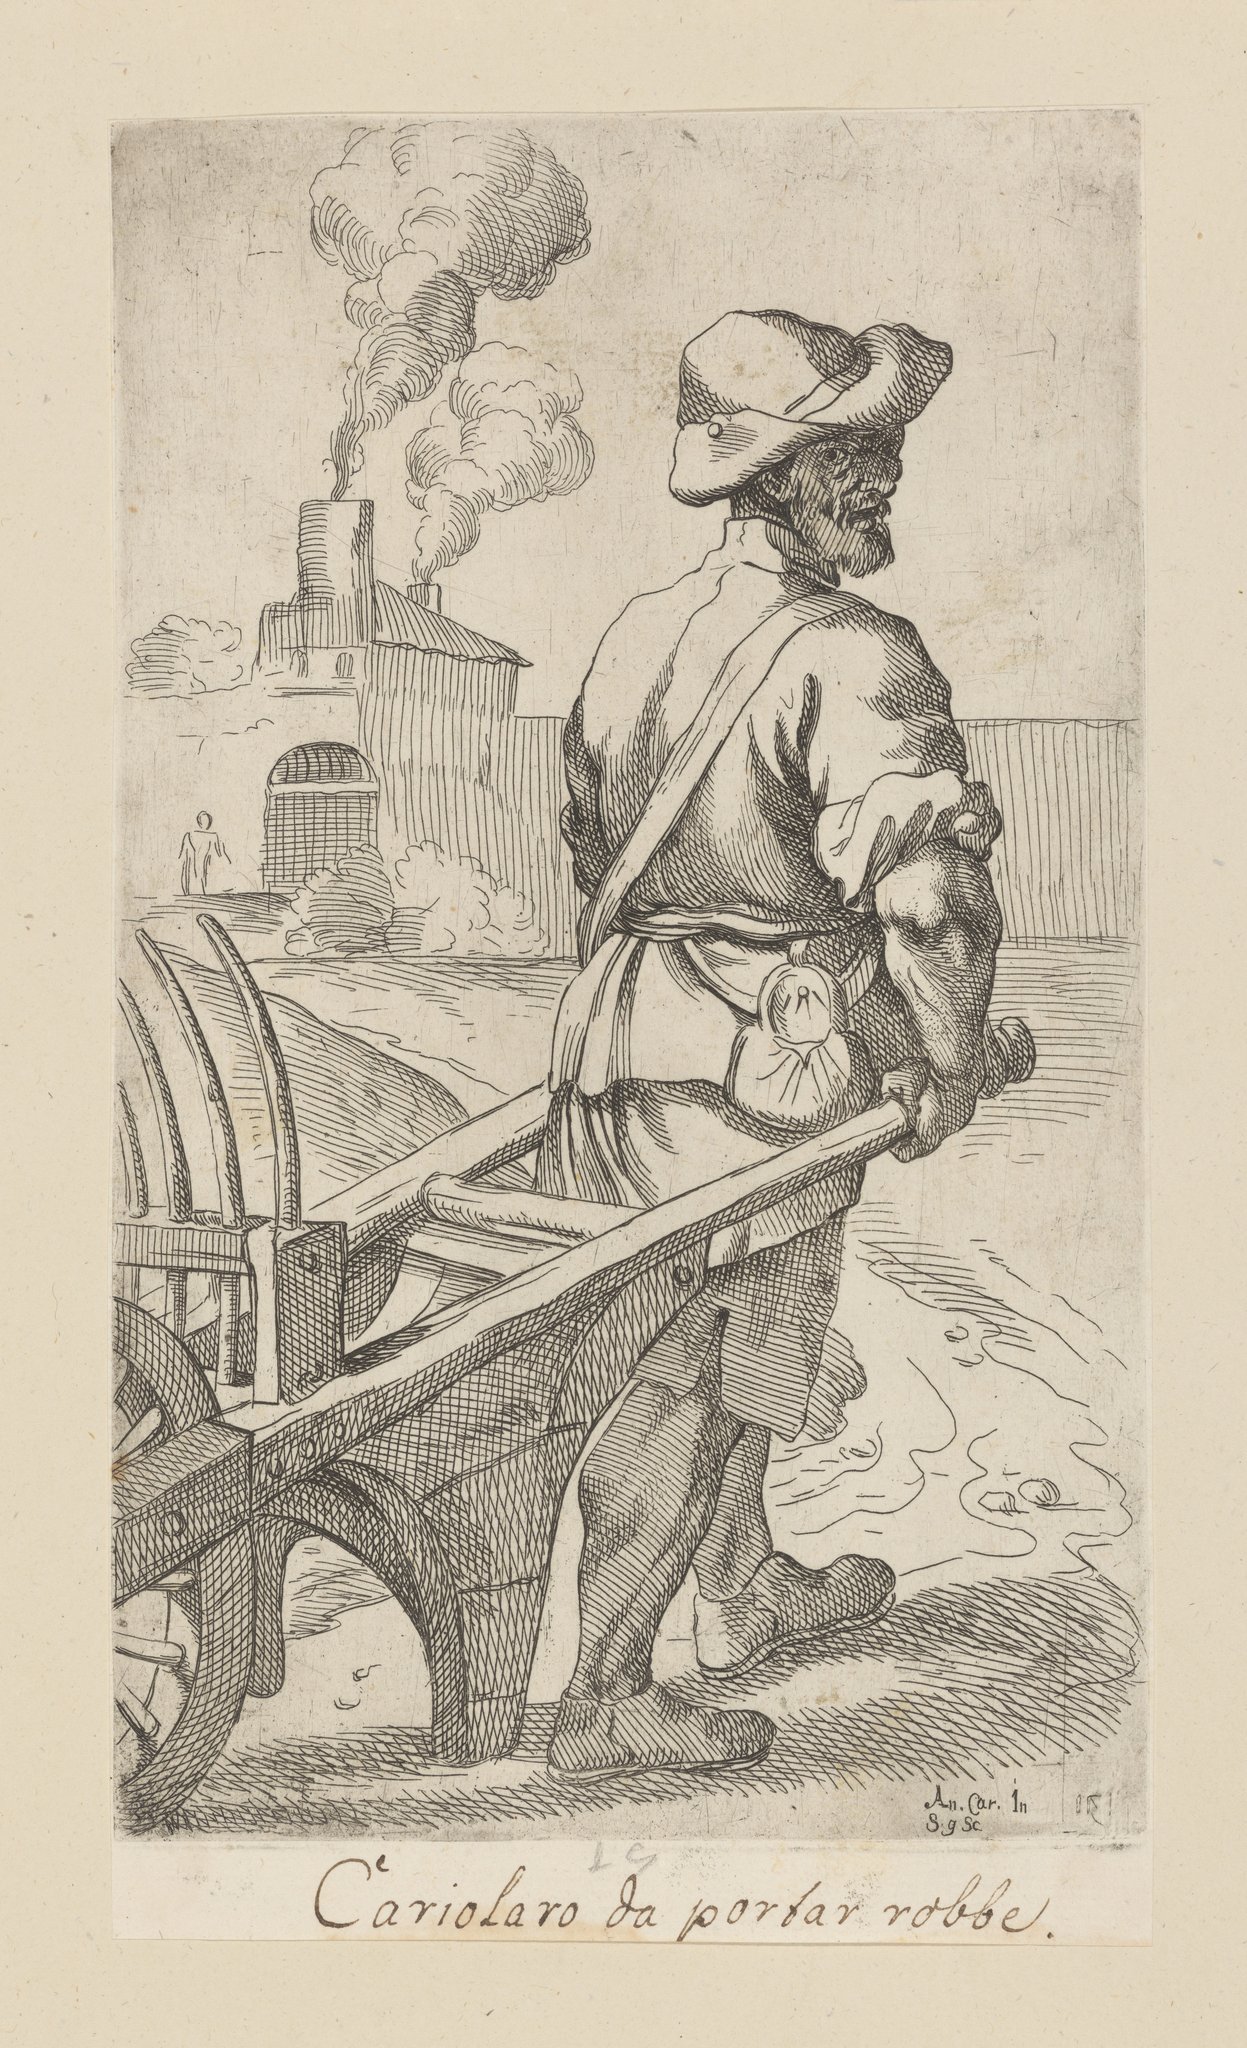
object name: print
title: Plate 11: Porter with a wagon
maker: simon guillain ii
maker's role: artist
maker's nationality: french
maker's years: 1618-1718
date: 1646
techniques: etching